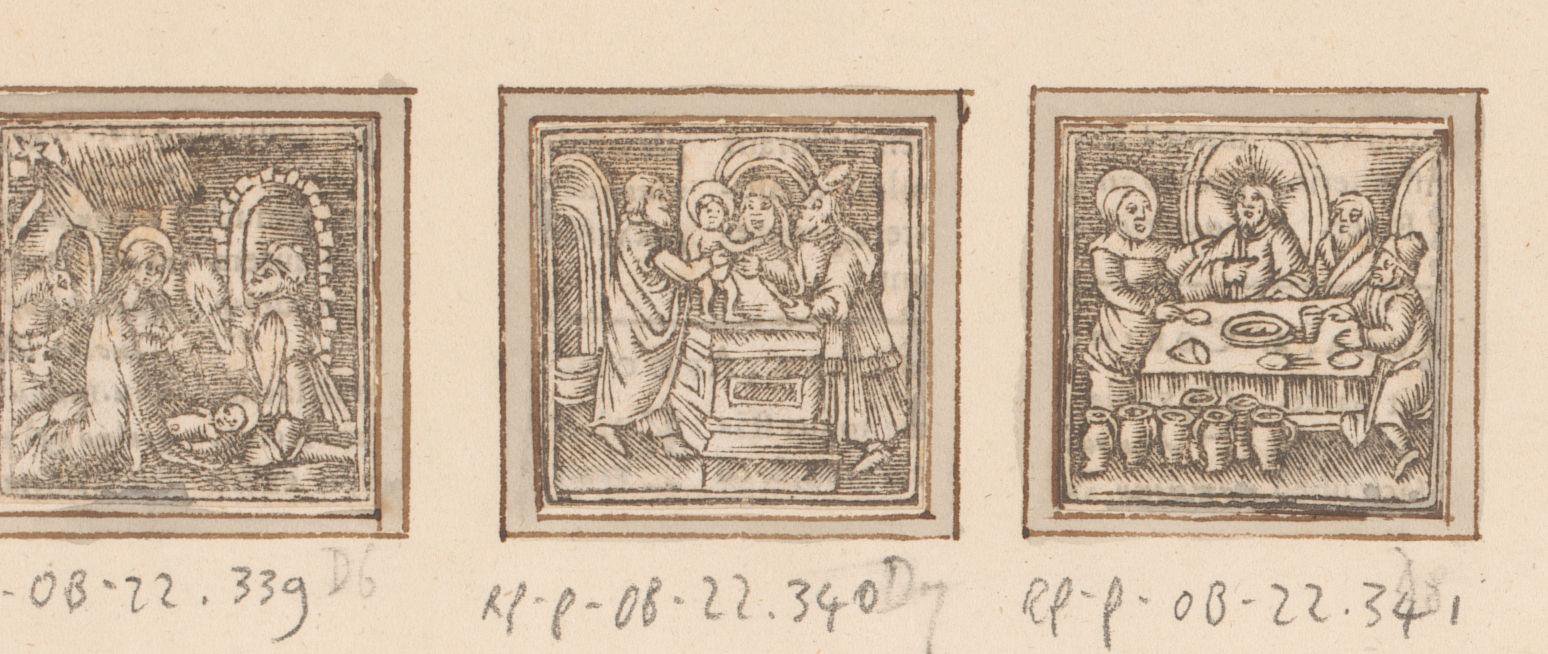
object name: print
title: Presentatie van Christus in de tempel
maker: Anonymous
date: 1590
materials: paper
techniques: woodcut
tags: presentation of the christ-child in the temple, usually simeon (and anna) present (luke 2:22-39)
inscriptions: collector's mark: Lugt 240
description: Prent afkomstig uit een onbekende Latijnse bijbel, mogelijk gedateerd 1590.